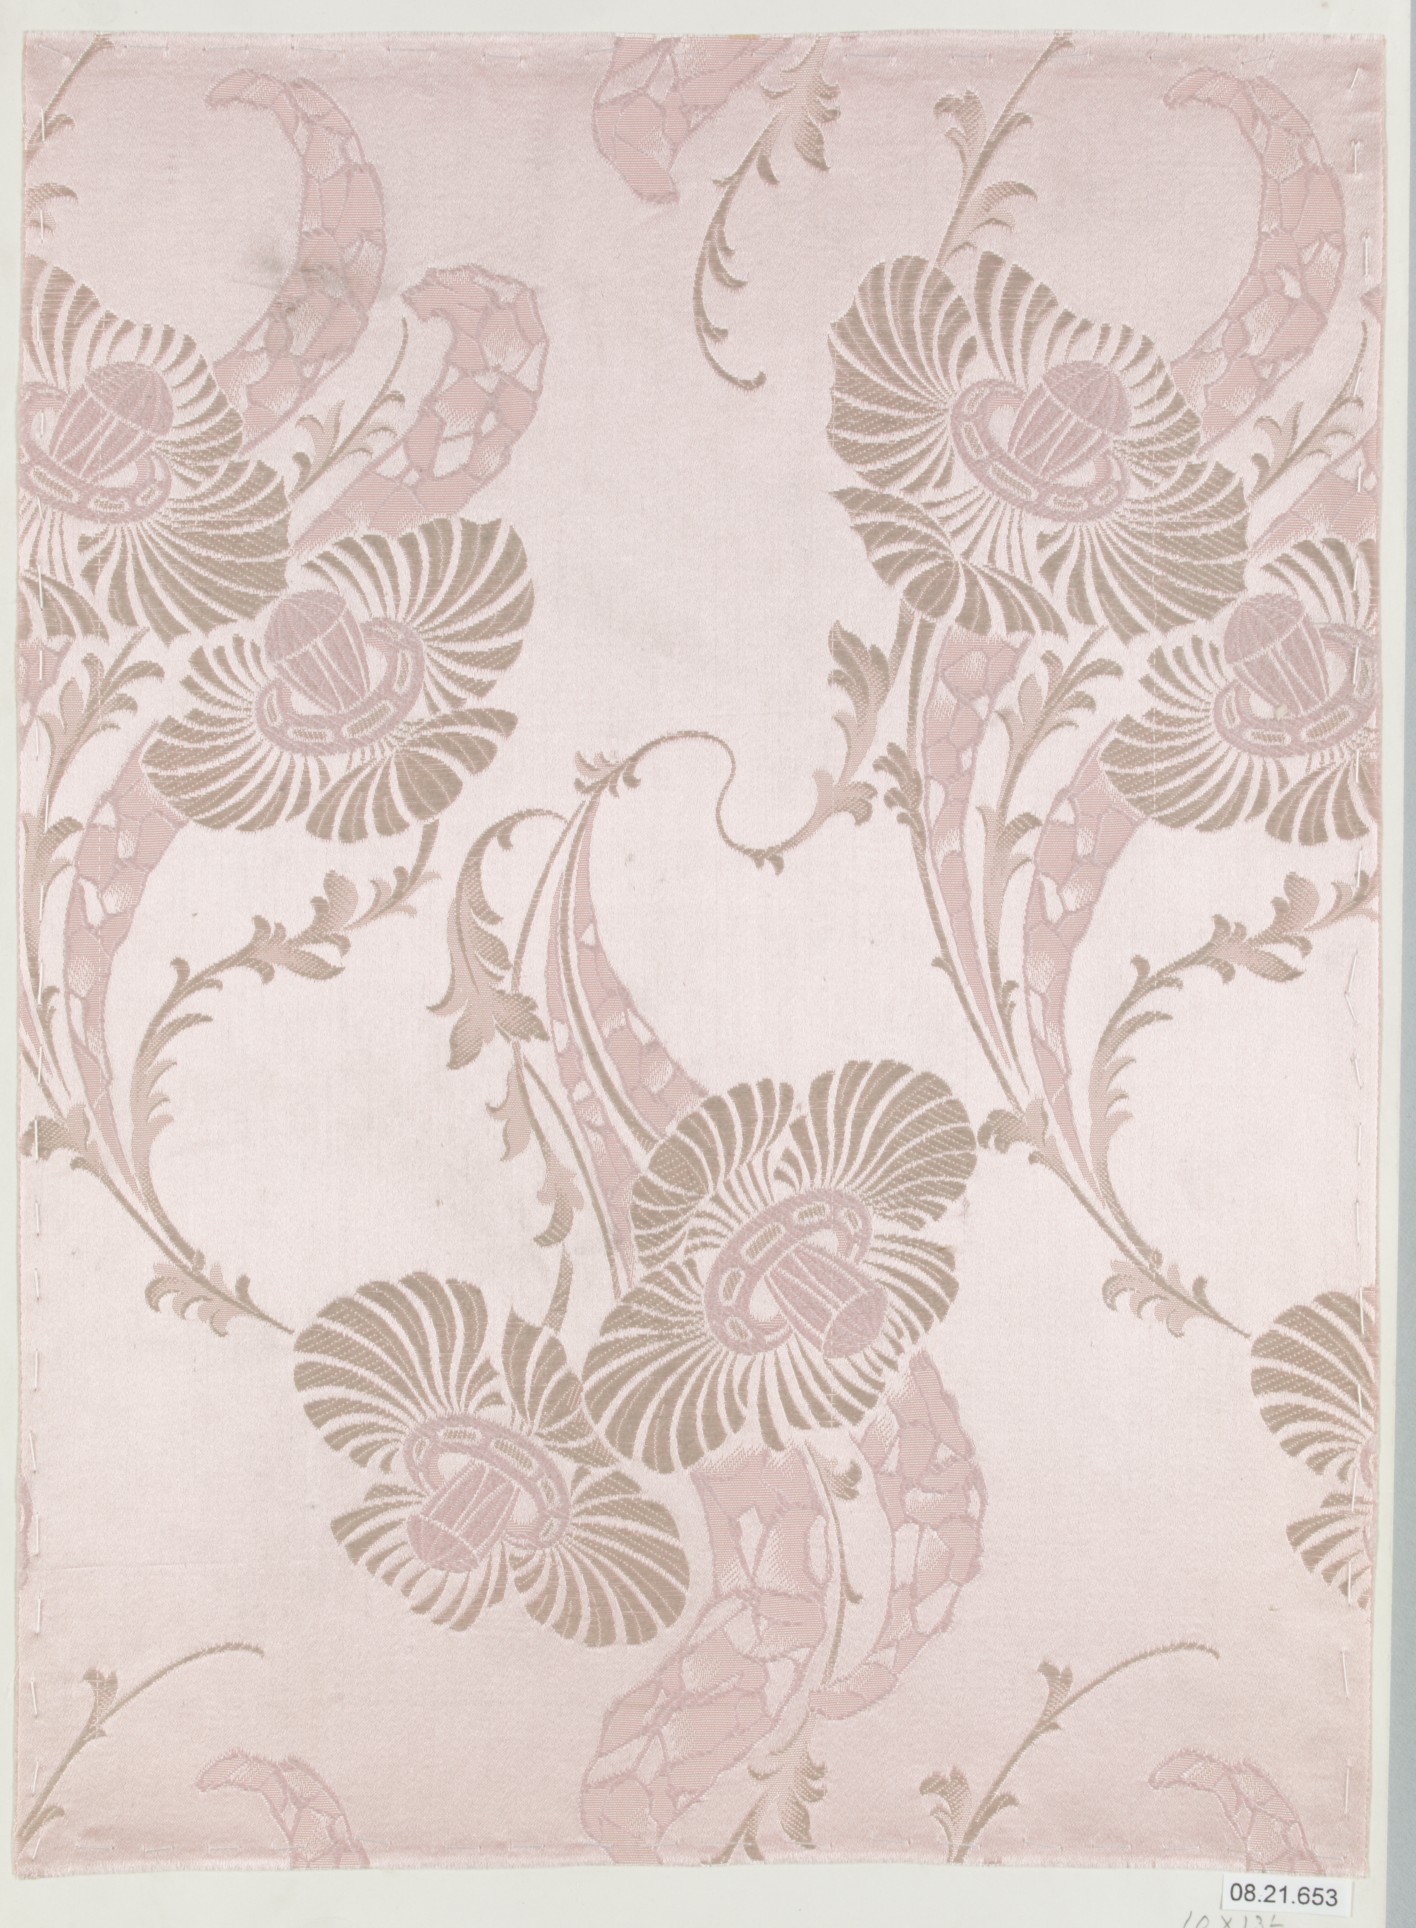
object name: textile sample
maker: Anonymous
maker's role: designer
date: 1900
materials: silk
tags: flowers